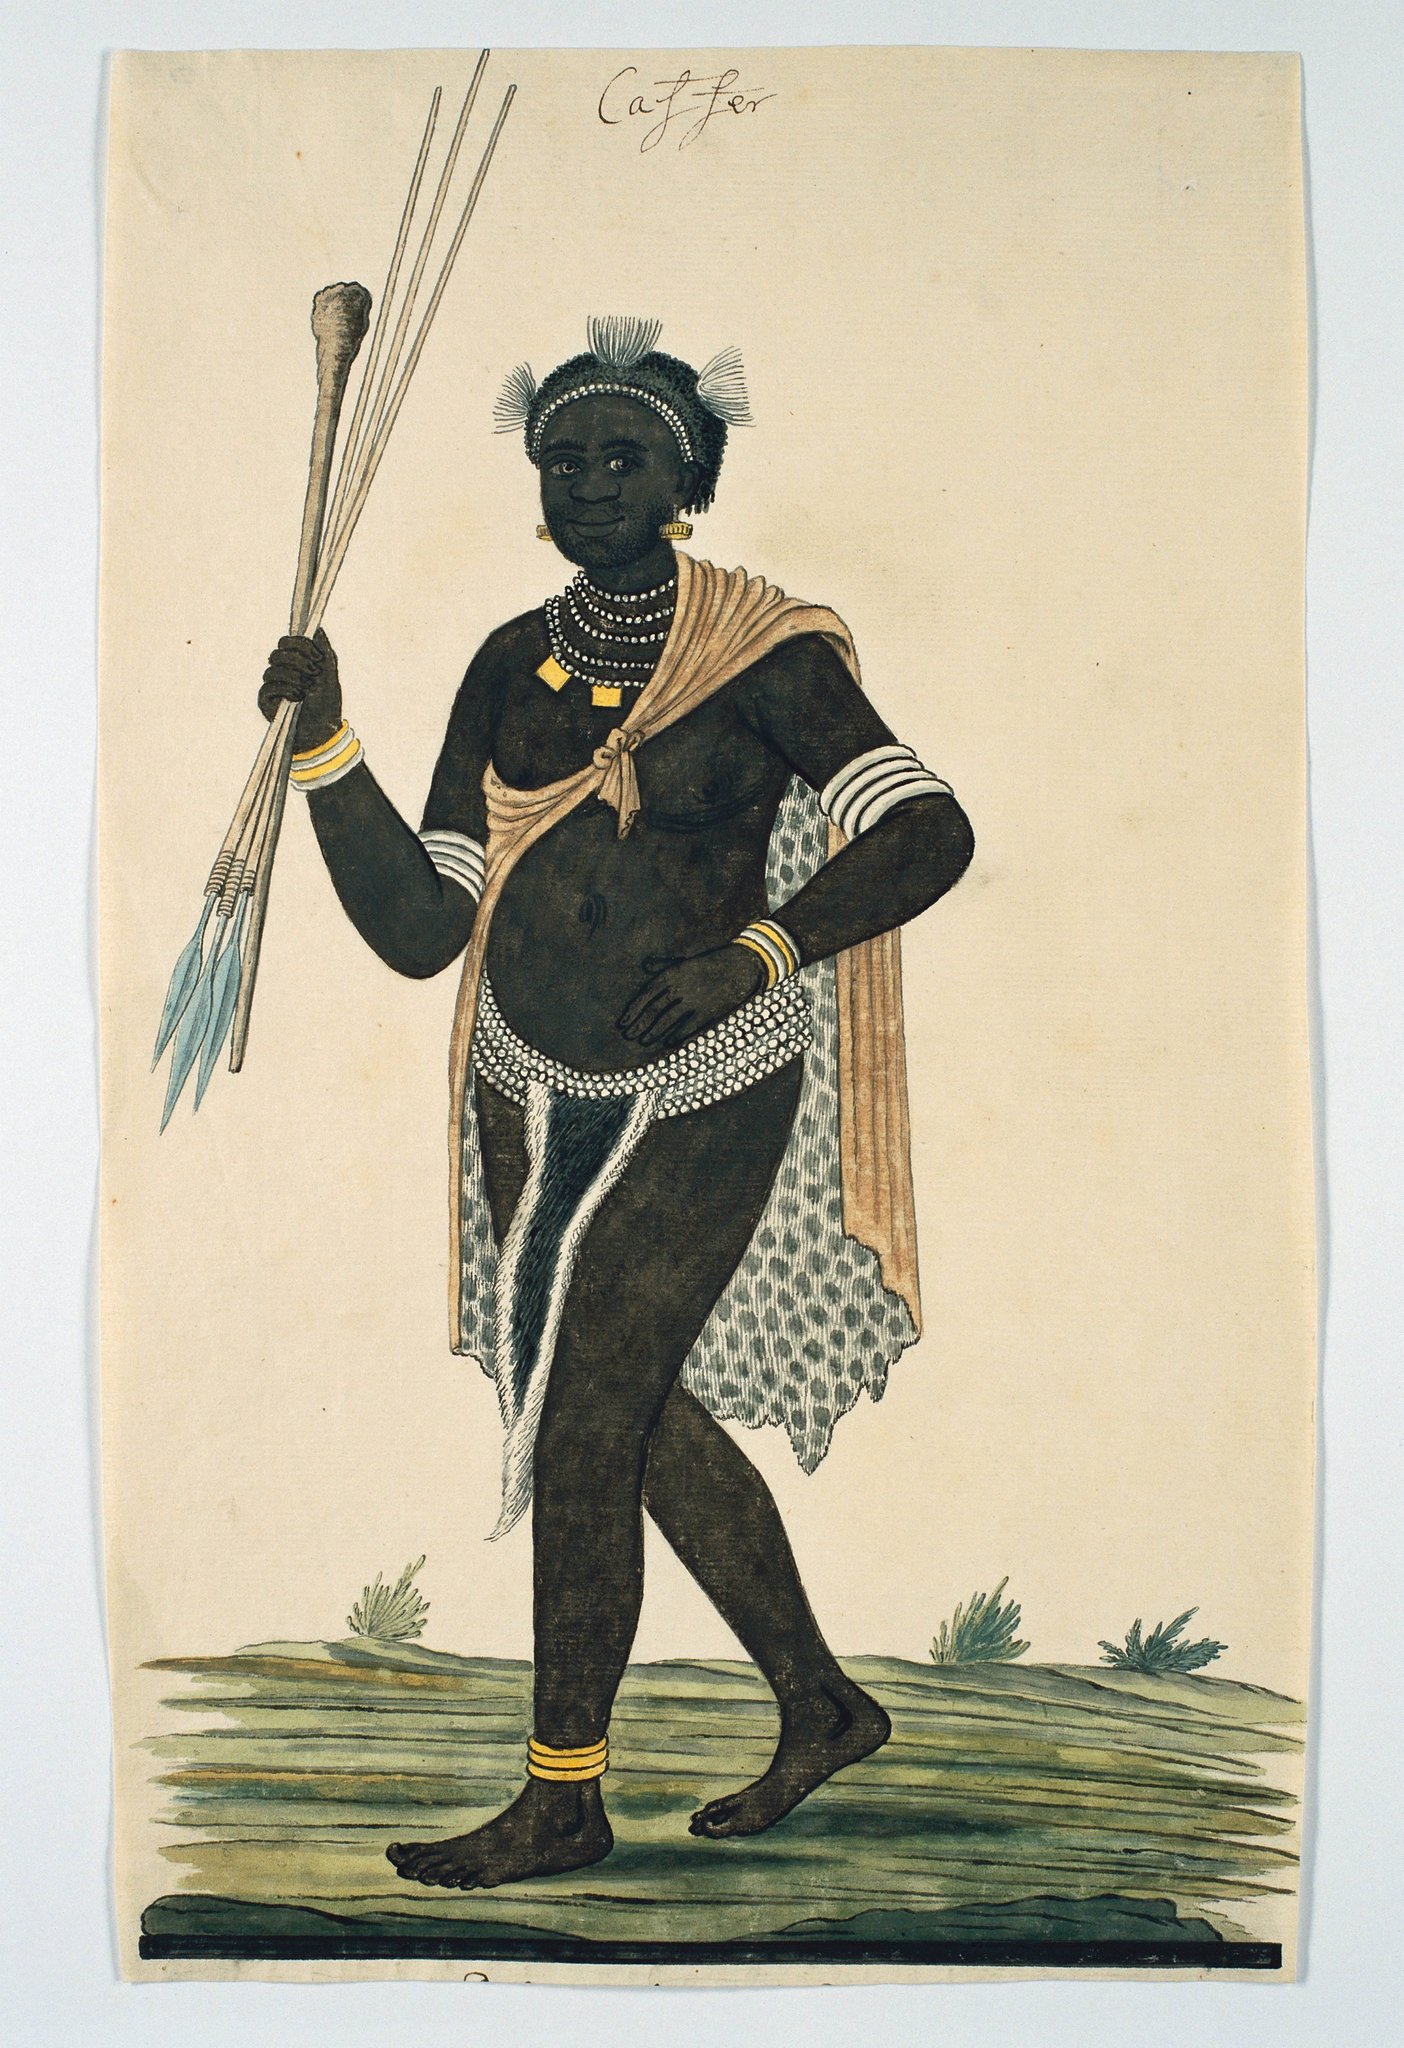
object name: drawing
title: Man holding three assegais and a knobkerrie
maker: robert jacob gordon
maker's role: draughtsman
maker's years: 1743-1795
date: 1776-1795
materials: paint, ink, paper, watercolor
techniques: brush, pen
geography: cape of good hope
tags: cape of good hope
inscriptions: annotation, top centre, handwritten in brown ink: ‘Caffer’ hand Sch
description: Xhosa met jachtgereedschap